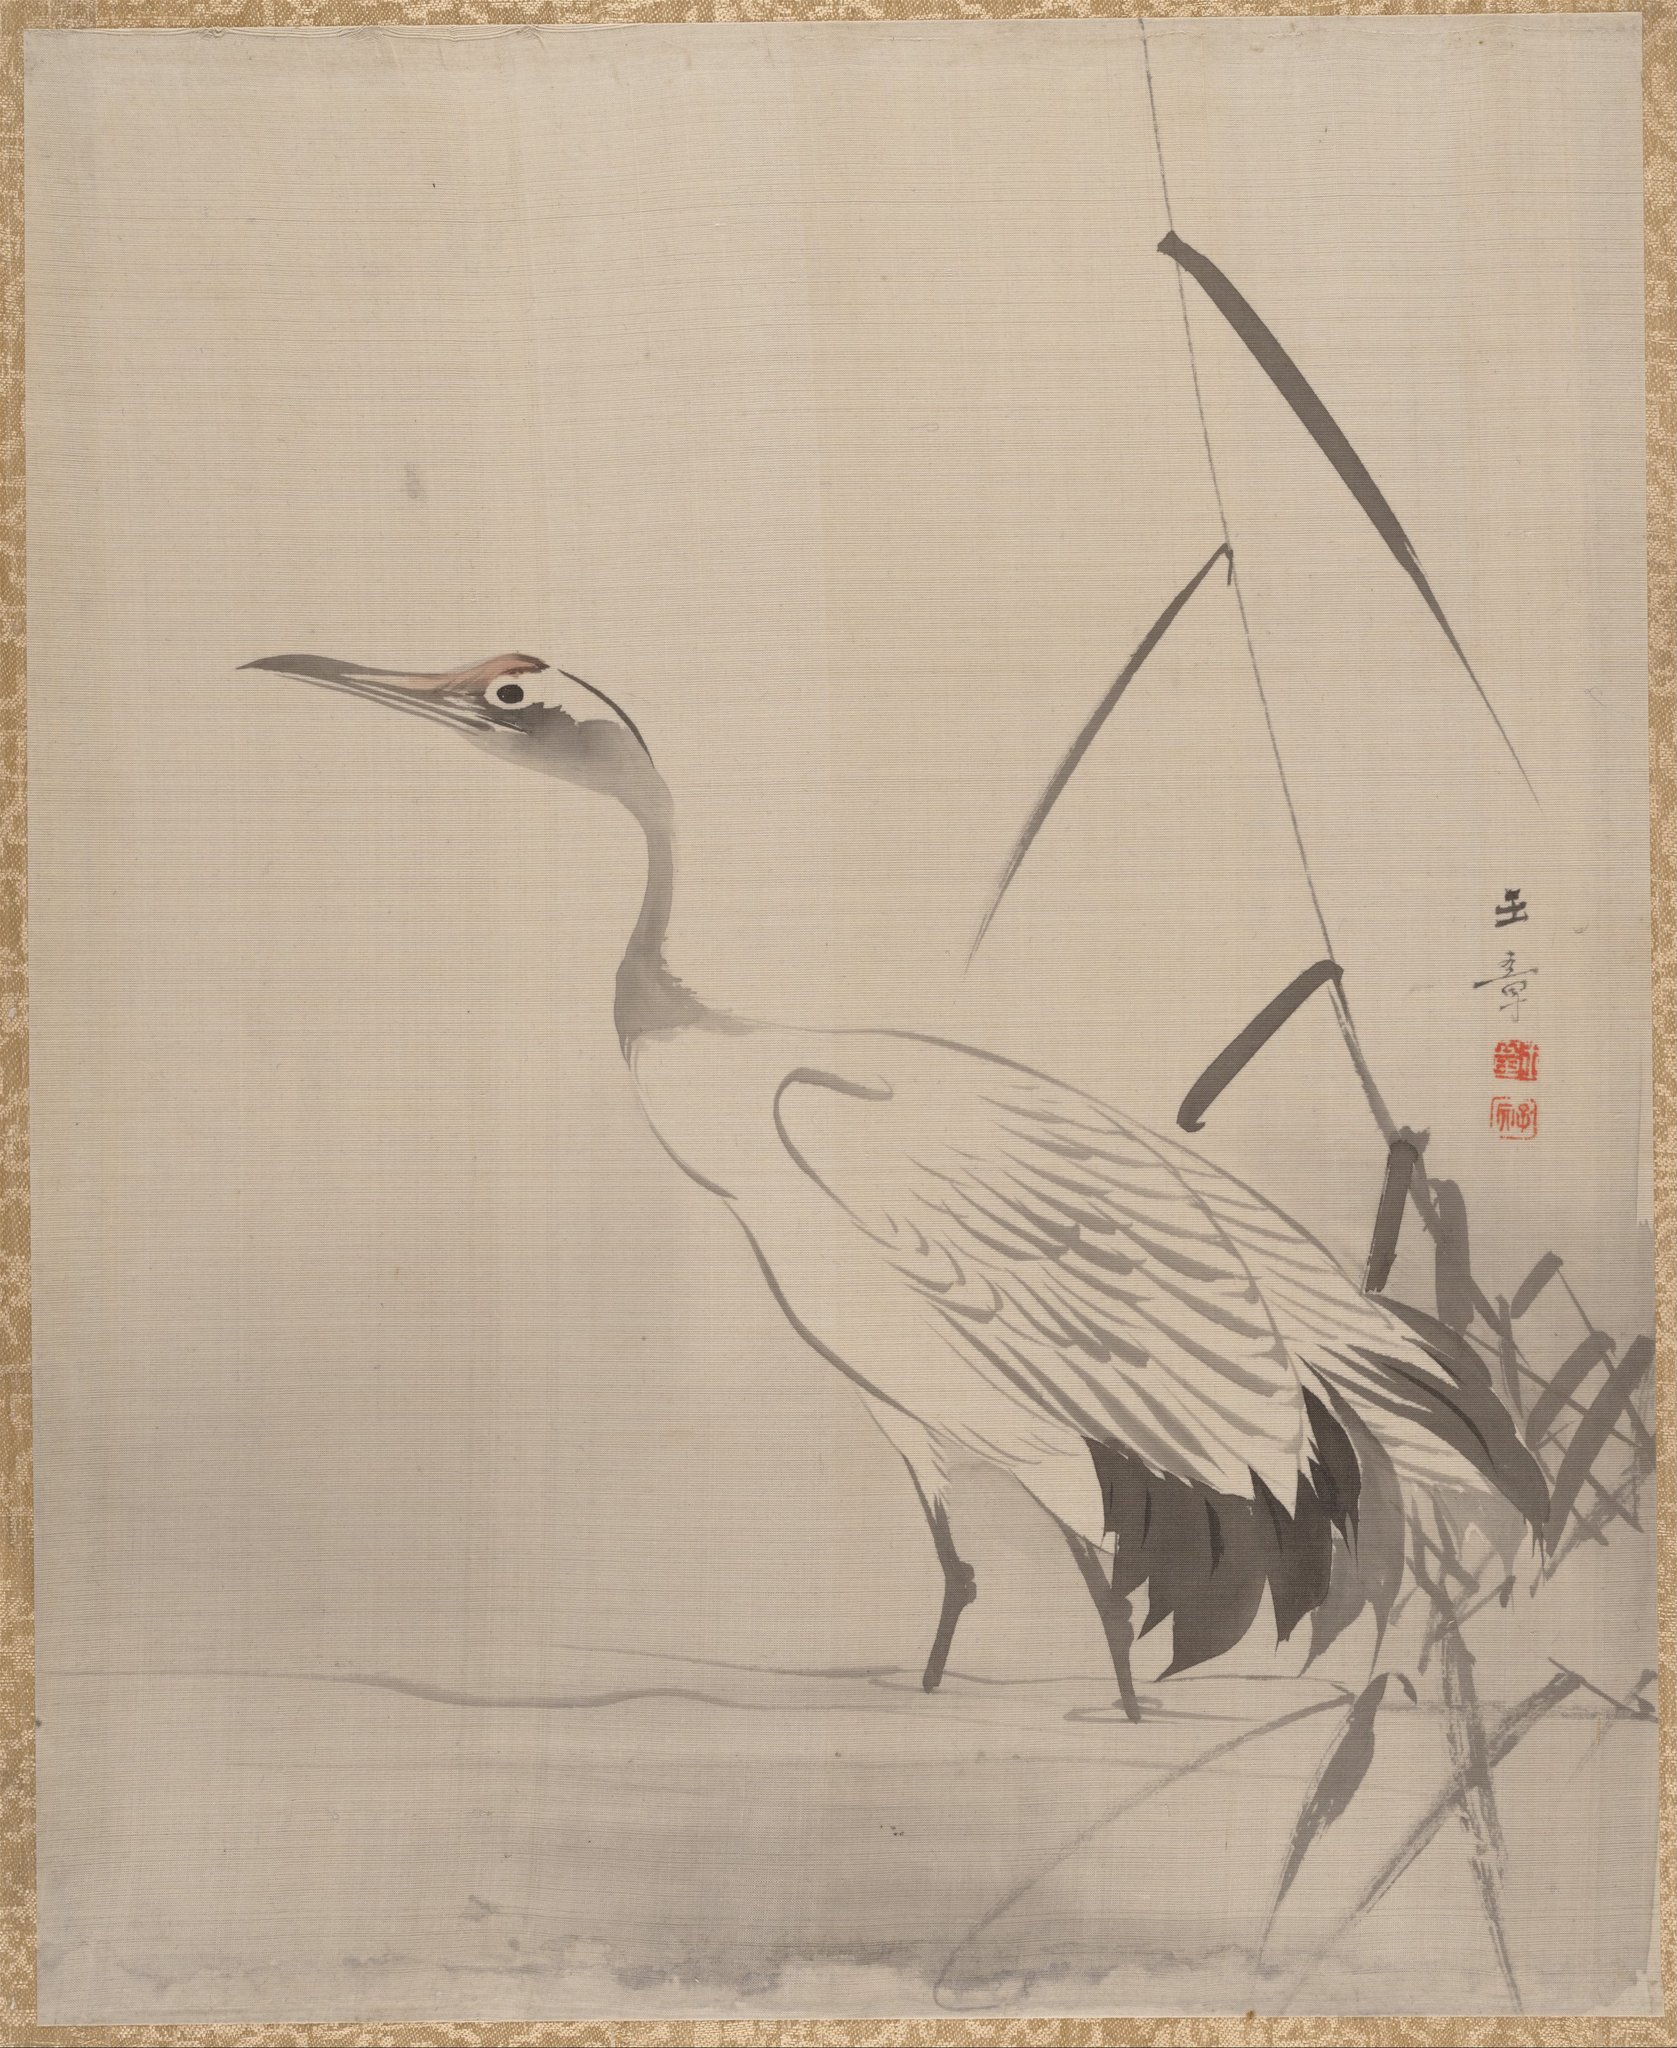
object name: album leaf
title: Crane Among Reeds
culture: japanese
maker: kawabata gyokushō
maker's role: artist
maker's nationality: japanese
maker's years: 1842-1913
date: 1887-1892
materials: silk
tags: cranes